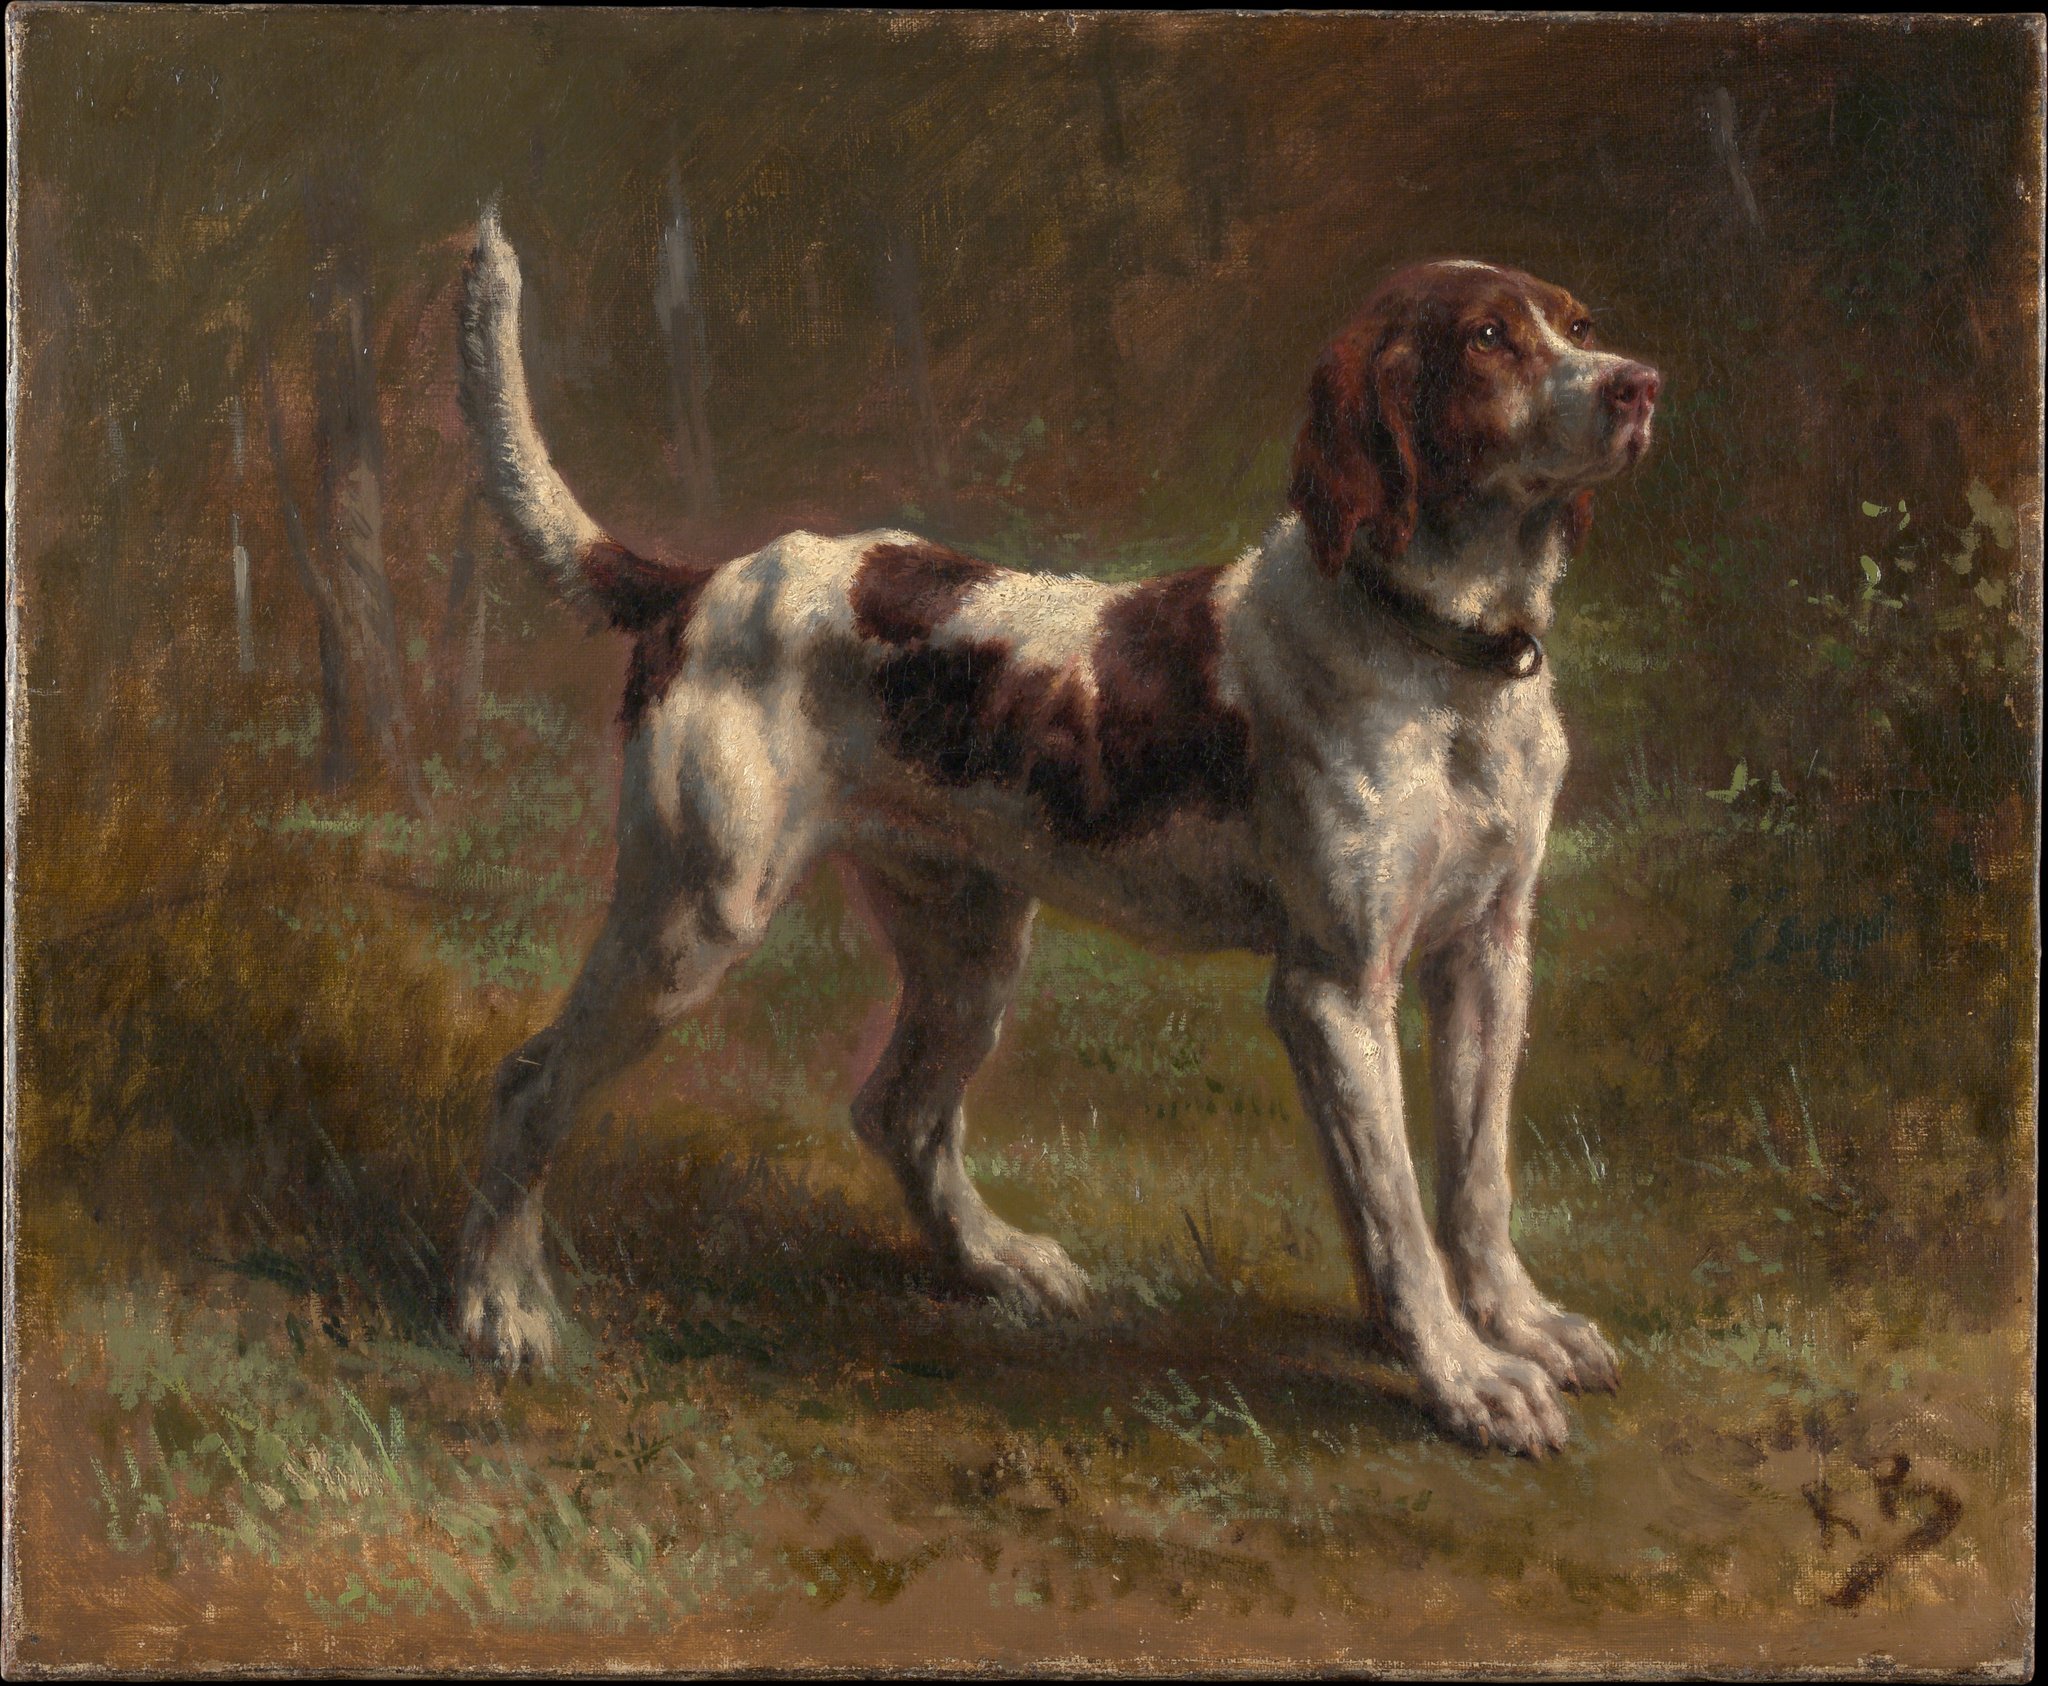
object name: painting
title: A Limier Briquet Hound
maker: rosa bonheur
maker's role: artist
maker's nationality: french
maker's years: 1822-1899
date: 1856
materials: canvas, oil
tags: dogs